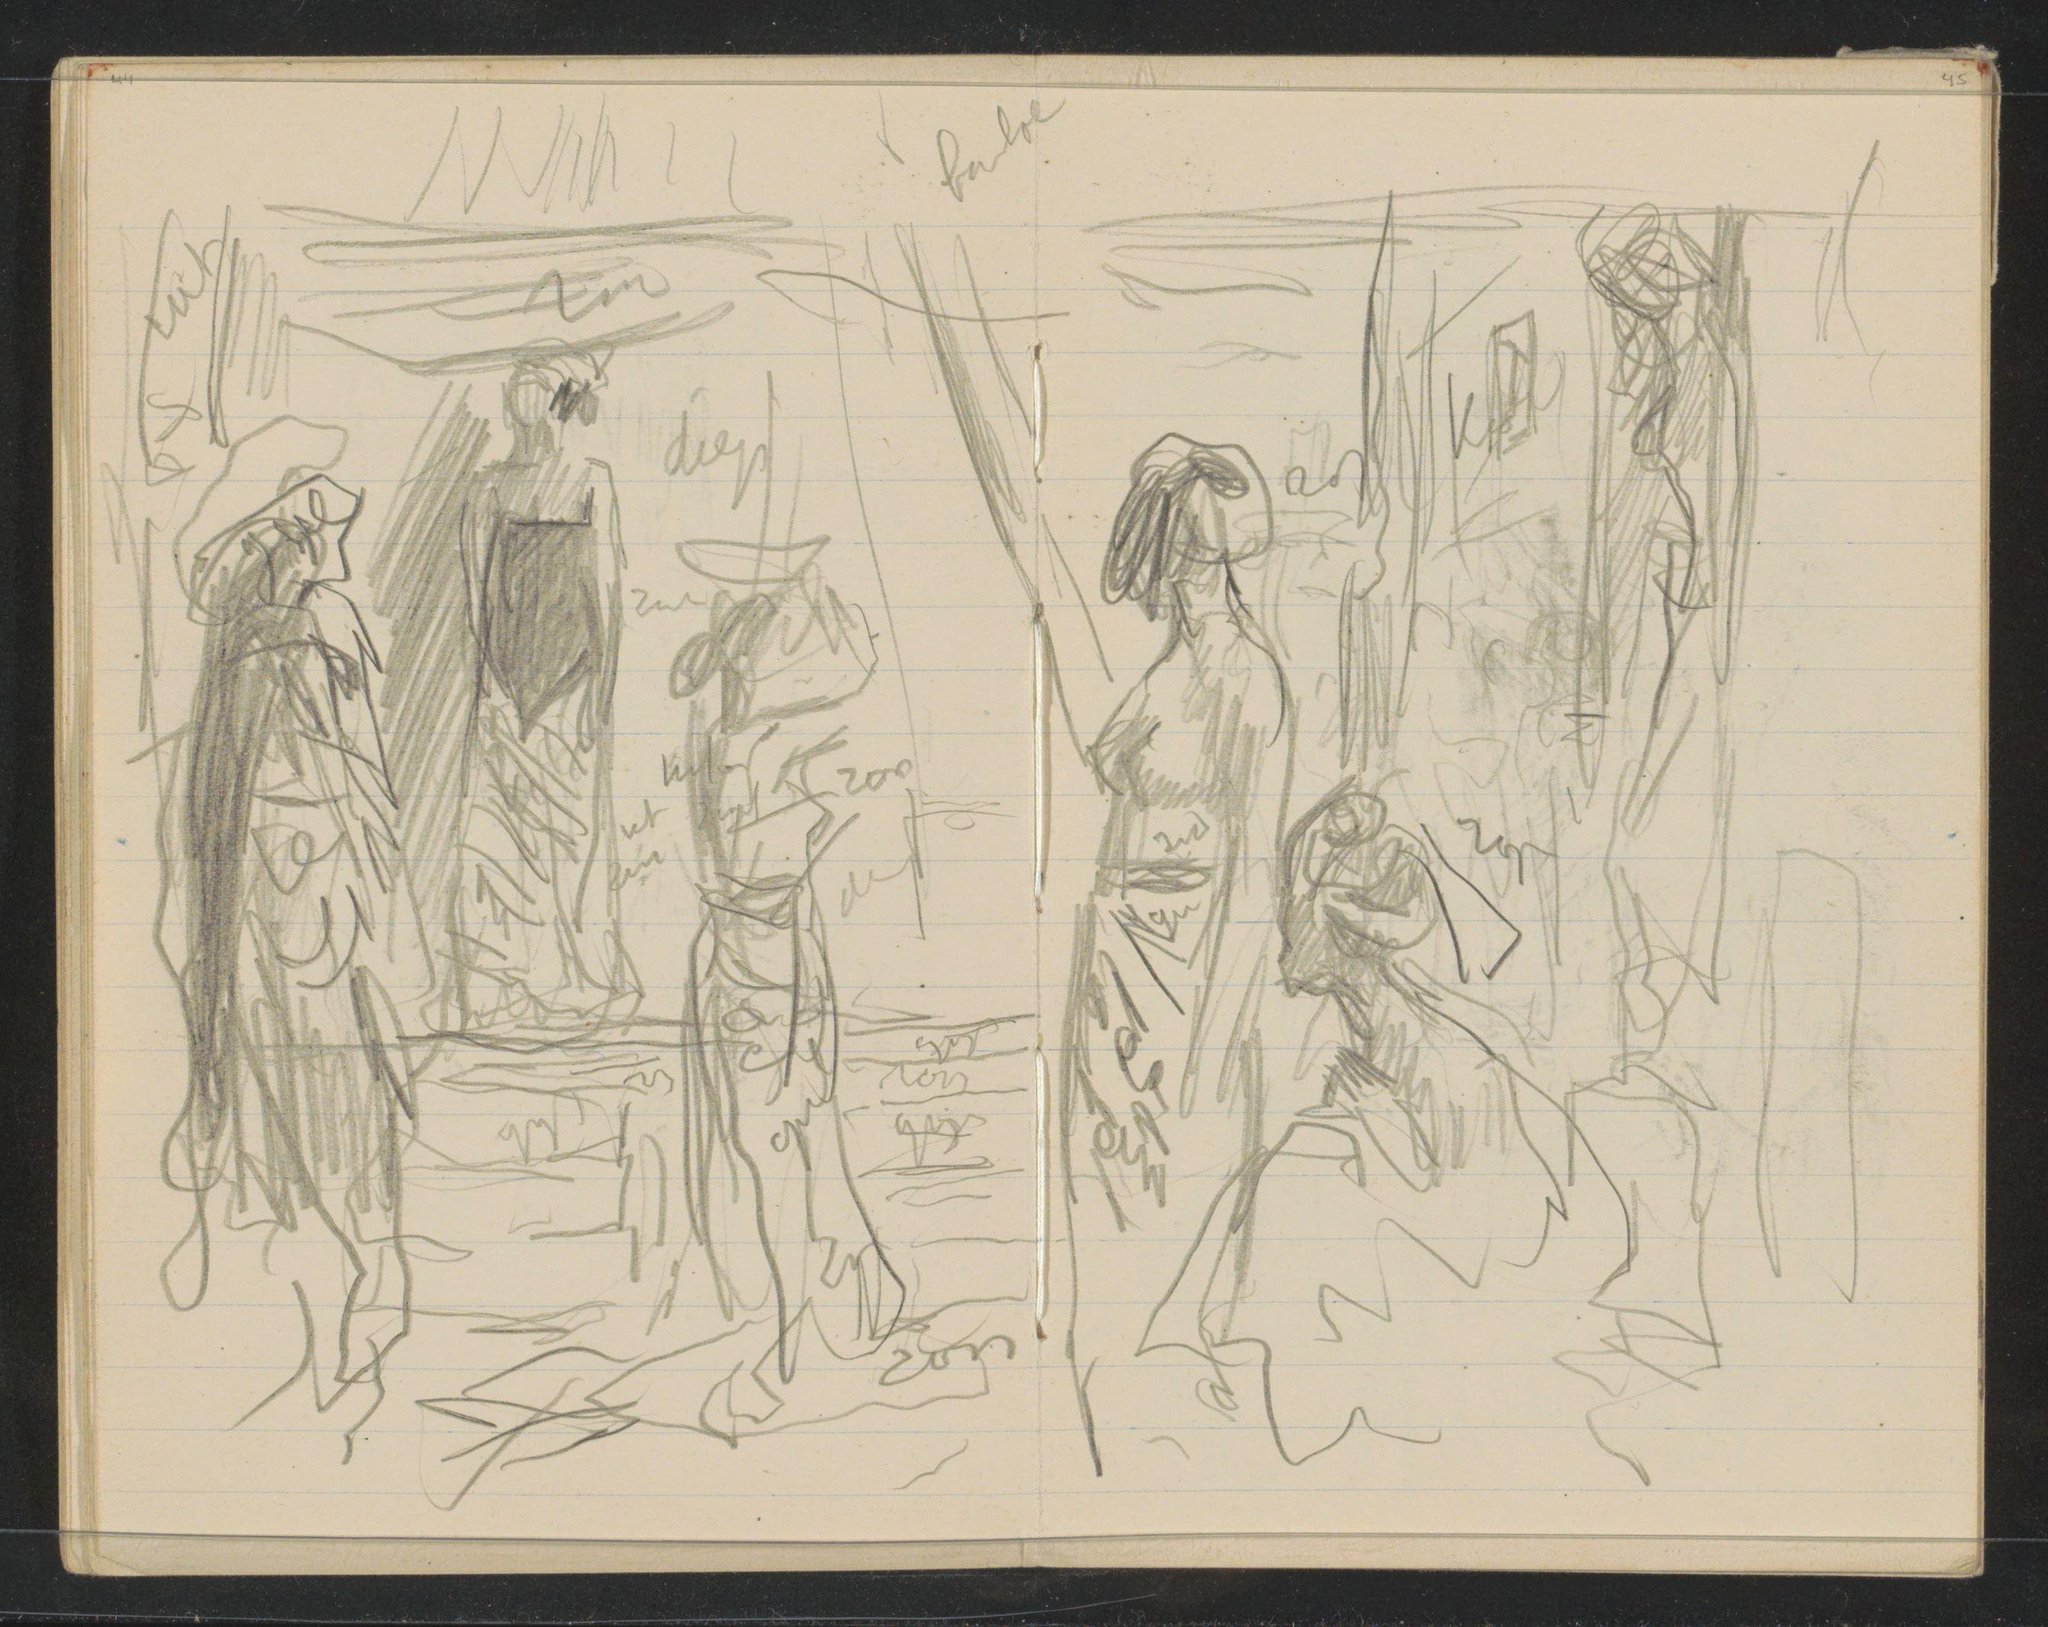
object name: sketchbook leaf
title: Indonesische vrouwen in een interieur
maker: marius bauer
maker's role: draughtsman, print maker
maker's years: 1867-1932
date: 1931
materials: pencil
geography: indonesia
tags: asiatic races and peoples, adult woman, interior of the house, folk costume, regional costume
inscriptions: kleurnotitie, handgeschreven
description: Pagina 44 en 45 uit een schetsboek met 74 bladen.